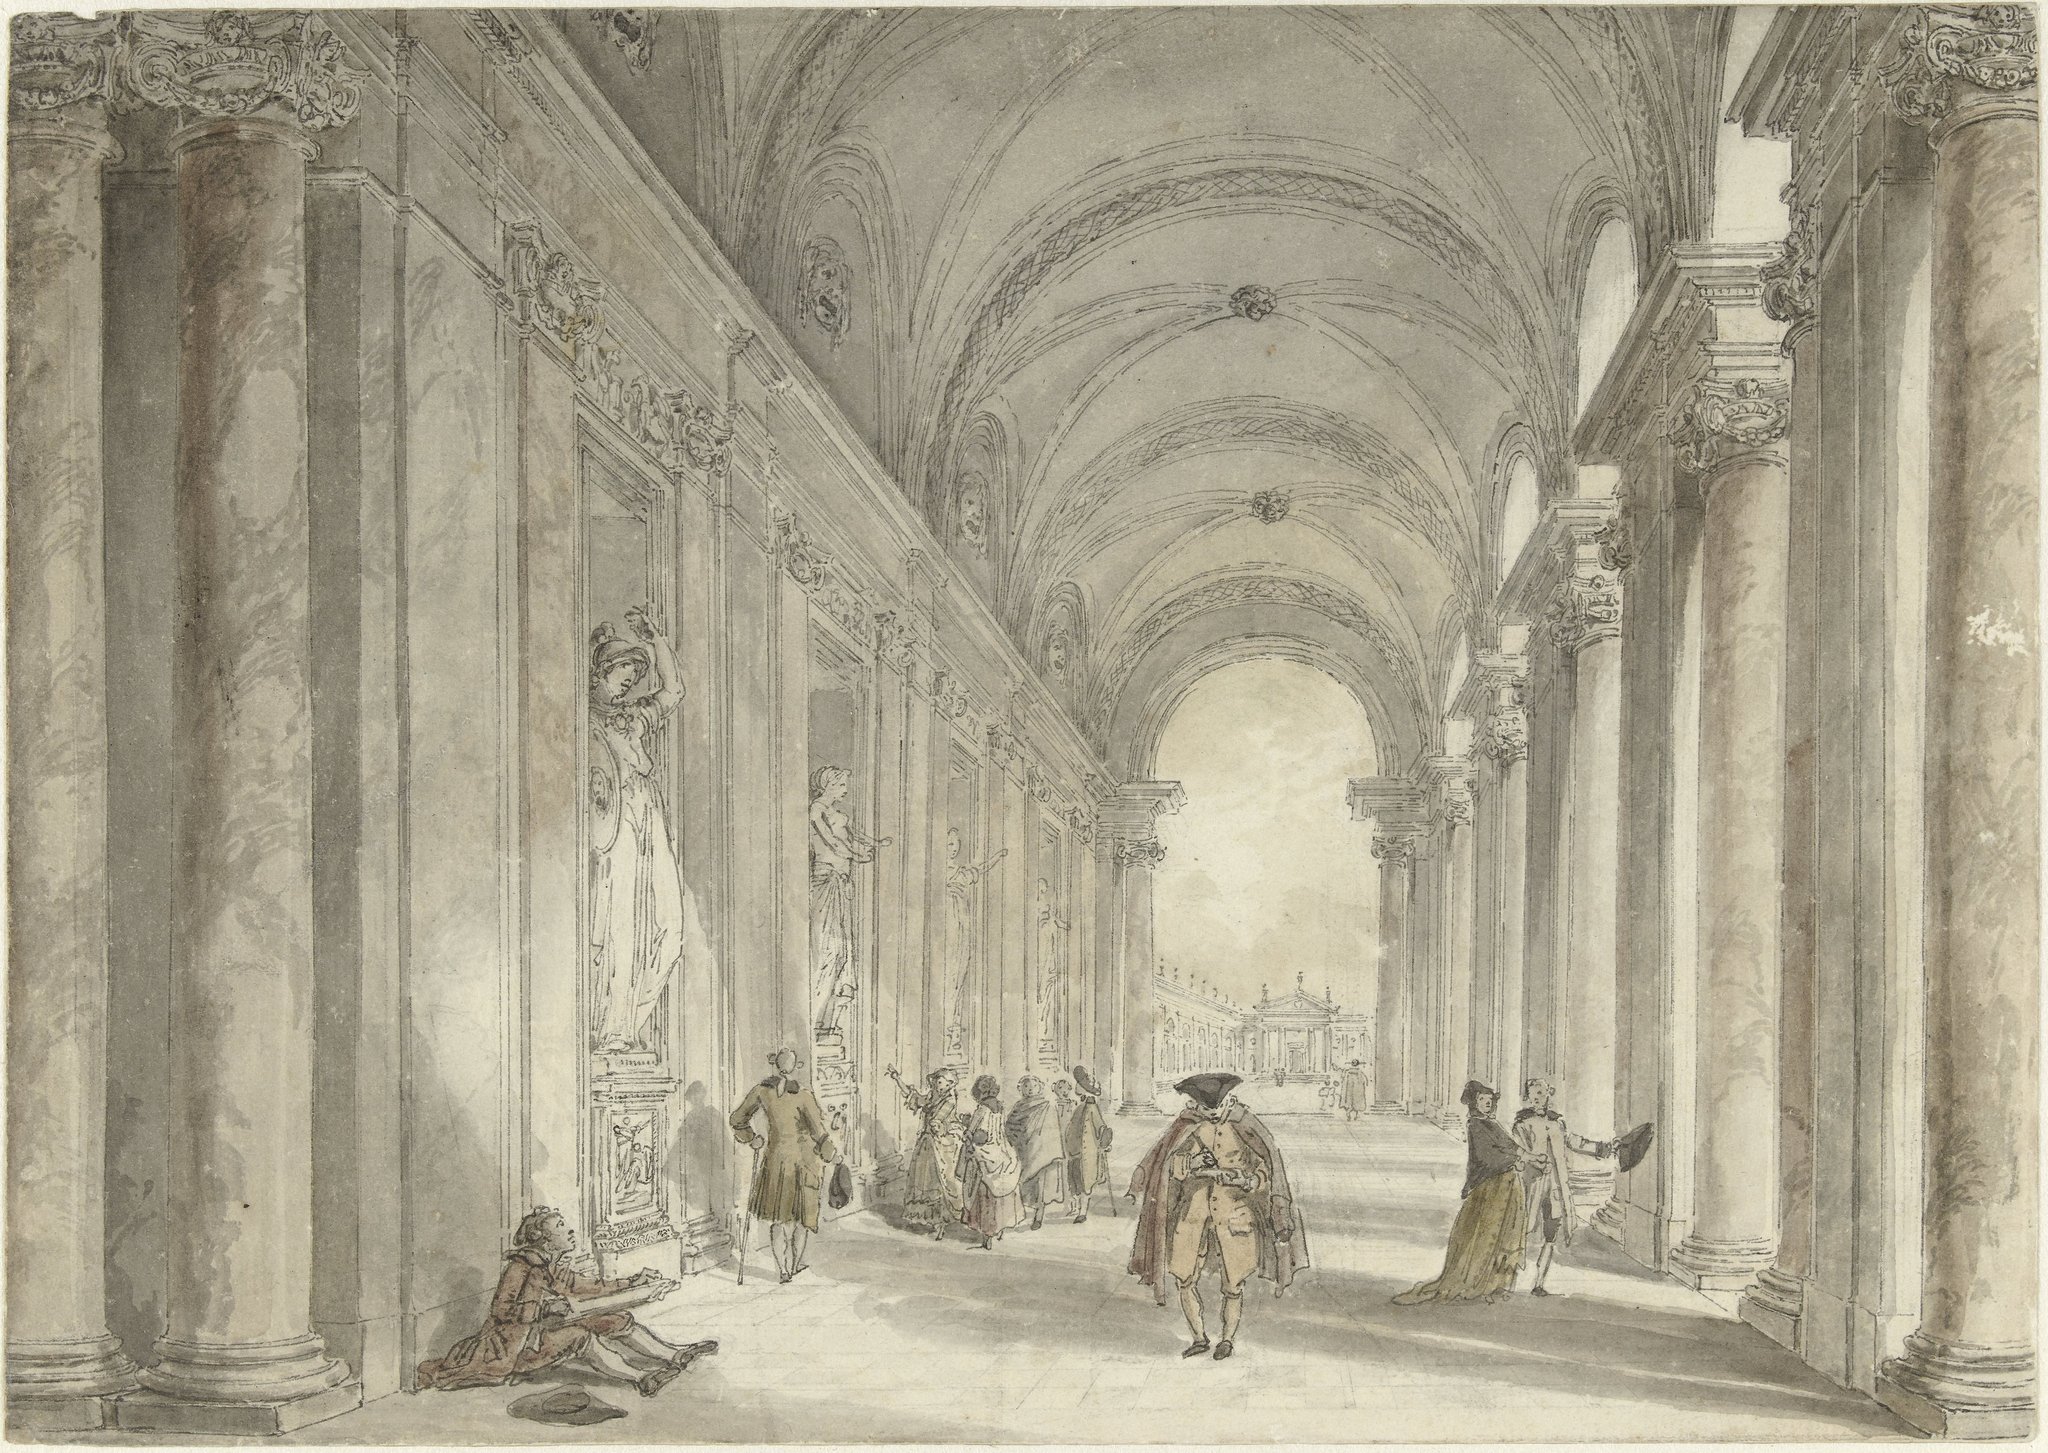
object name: drawing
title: Colonnade of the Casino of the Villa Albani, in Rome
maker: hubert robert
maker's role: draughtsman, print maker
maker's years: 1733-1808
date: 1763-1764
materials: paper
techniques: brush, pen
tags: draughtsman studying classical remains - cc - out of doors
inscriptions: collector's mark: Lugt 2228a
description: Cardinal Albani owned a famous collection of antique statues, which was displayed in his luxurious villa. Artists in training were invited to draw in this private museum, as reflected by the young man sketching on the left. Hubert Robert, an architectural draughtsman, had a keen eye for detail: even the veins of the marble columns are visible. He enlivened the scene with elegant figures.